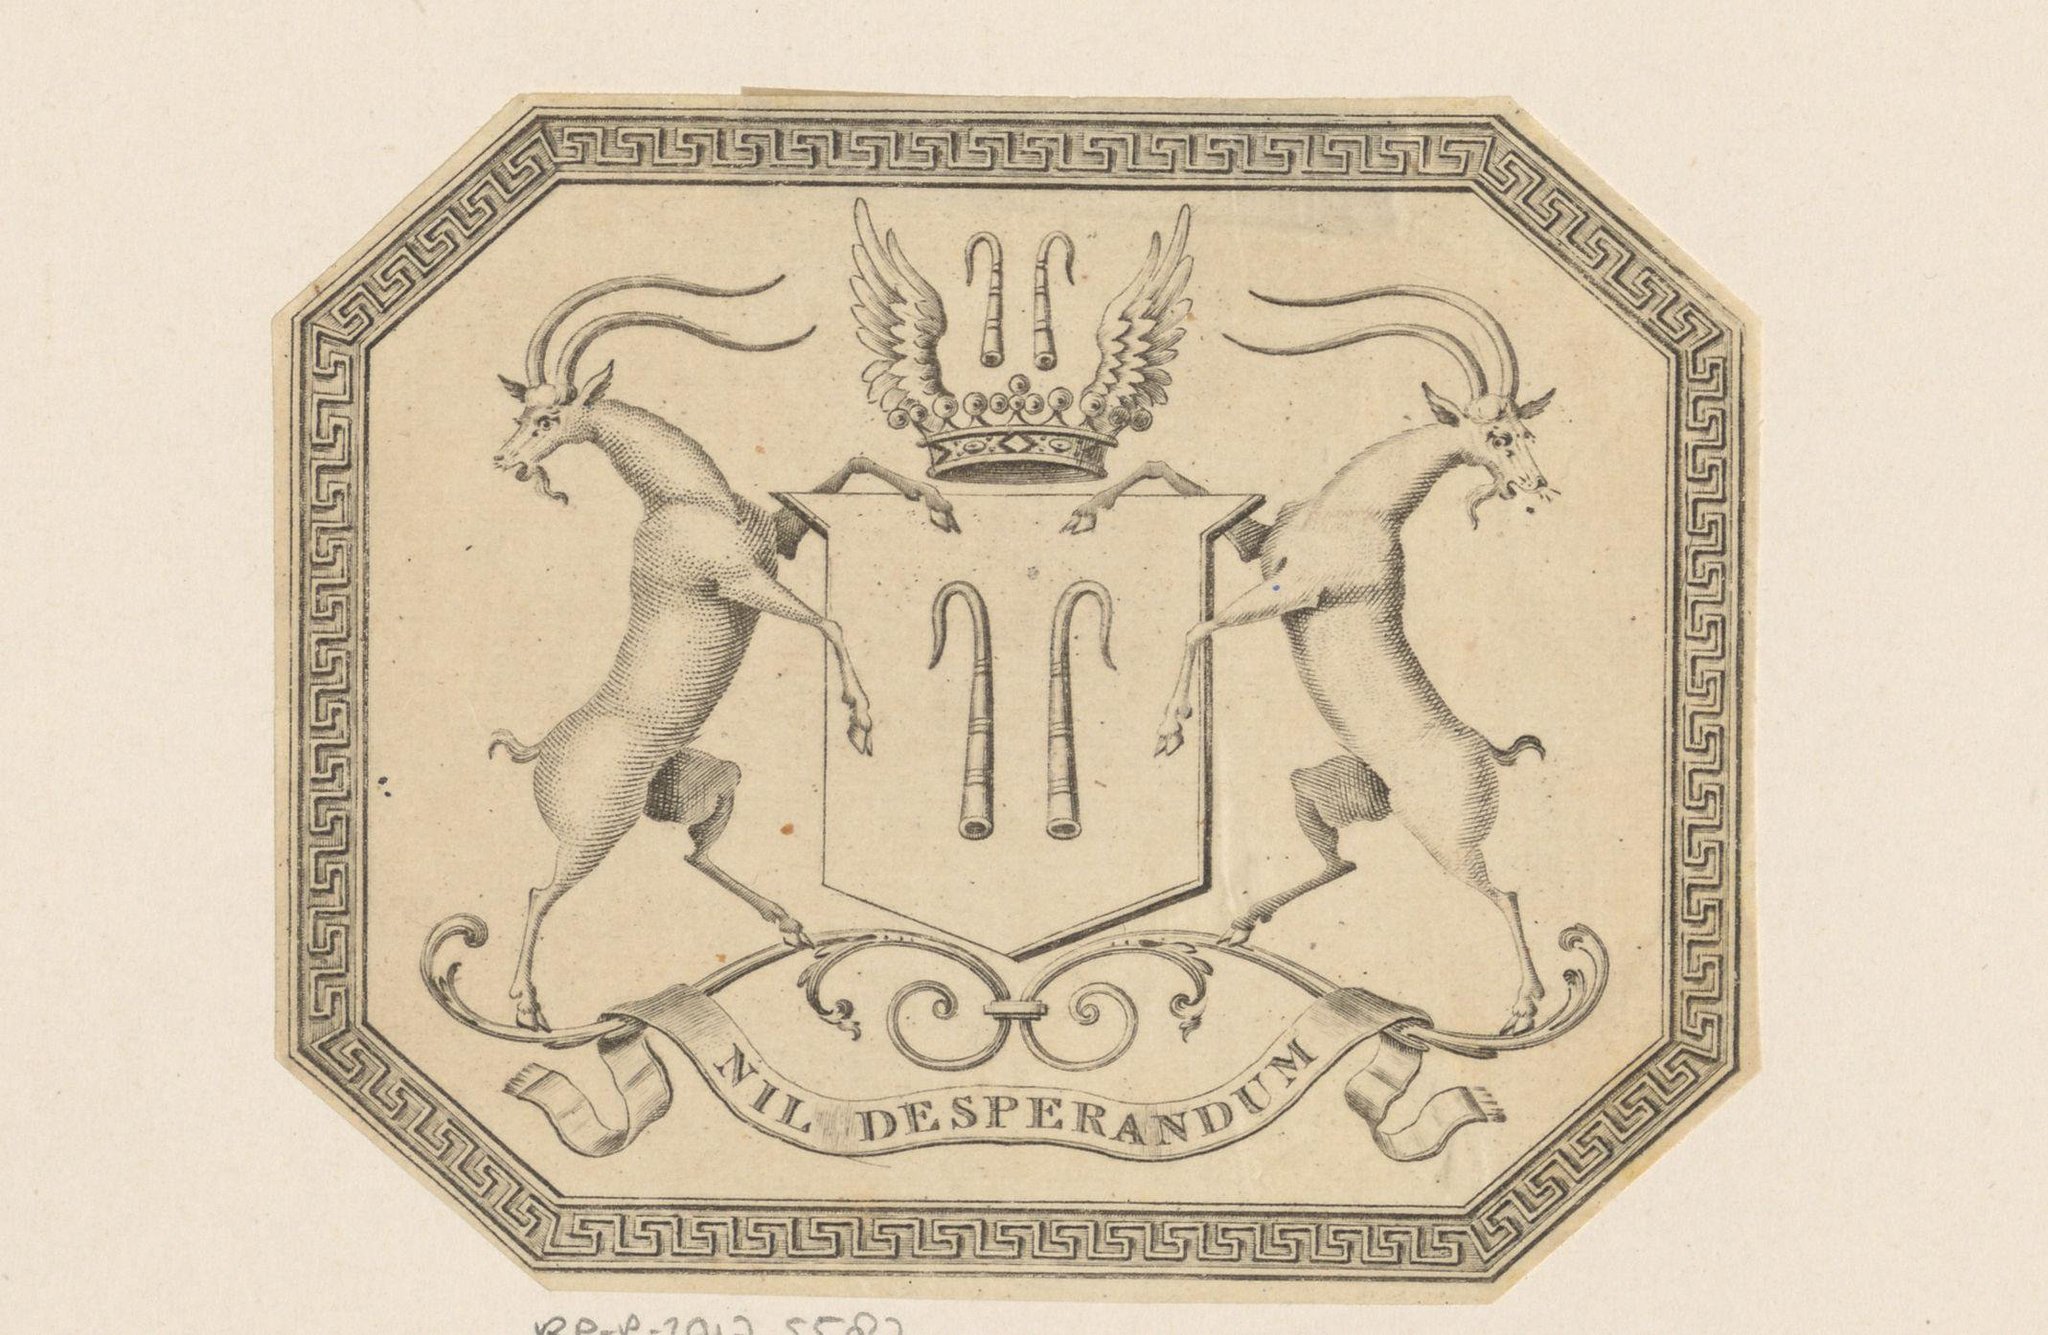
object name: bookplate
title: Nil disperandum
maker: Anonymous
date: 1800-1899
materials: paper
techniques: etching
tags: ram, armorial bearing, heraldry